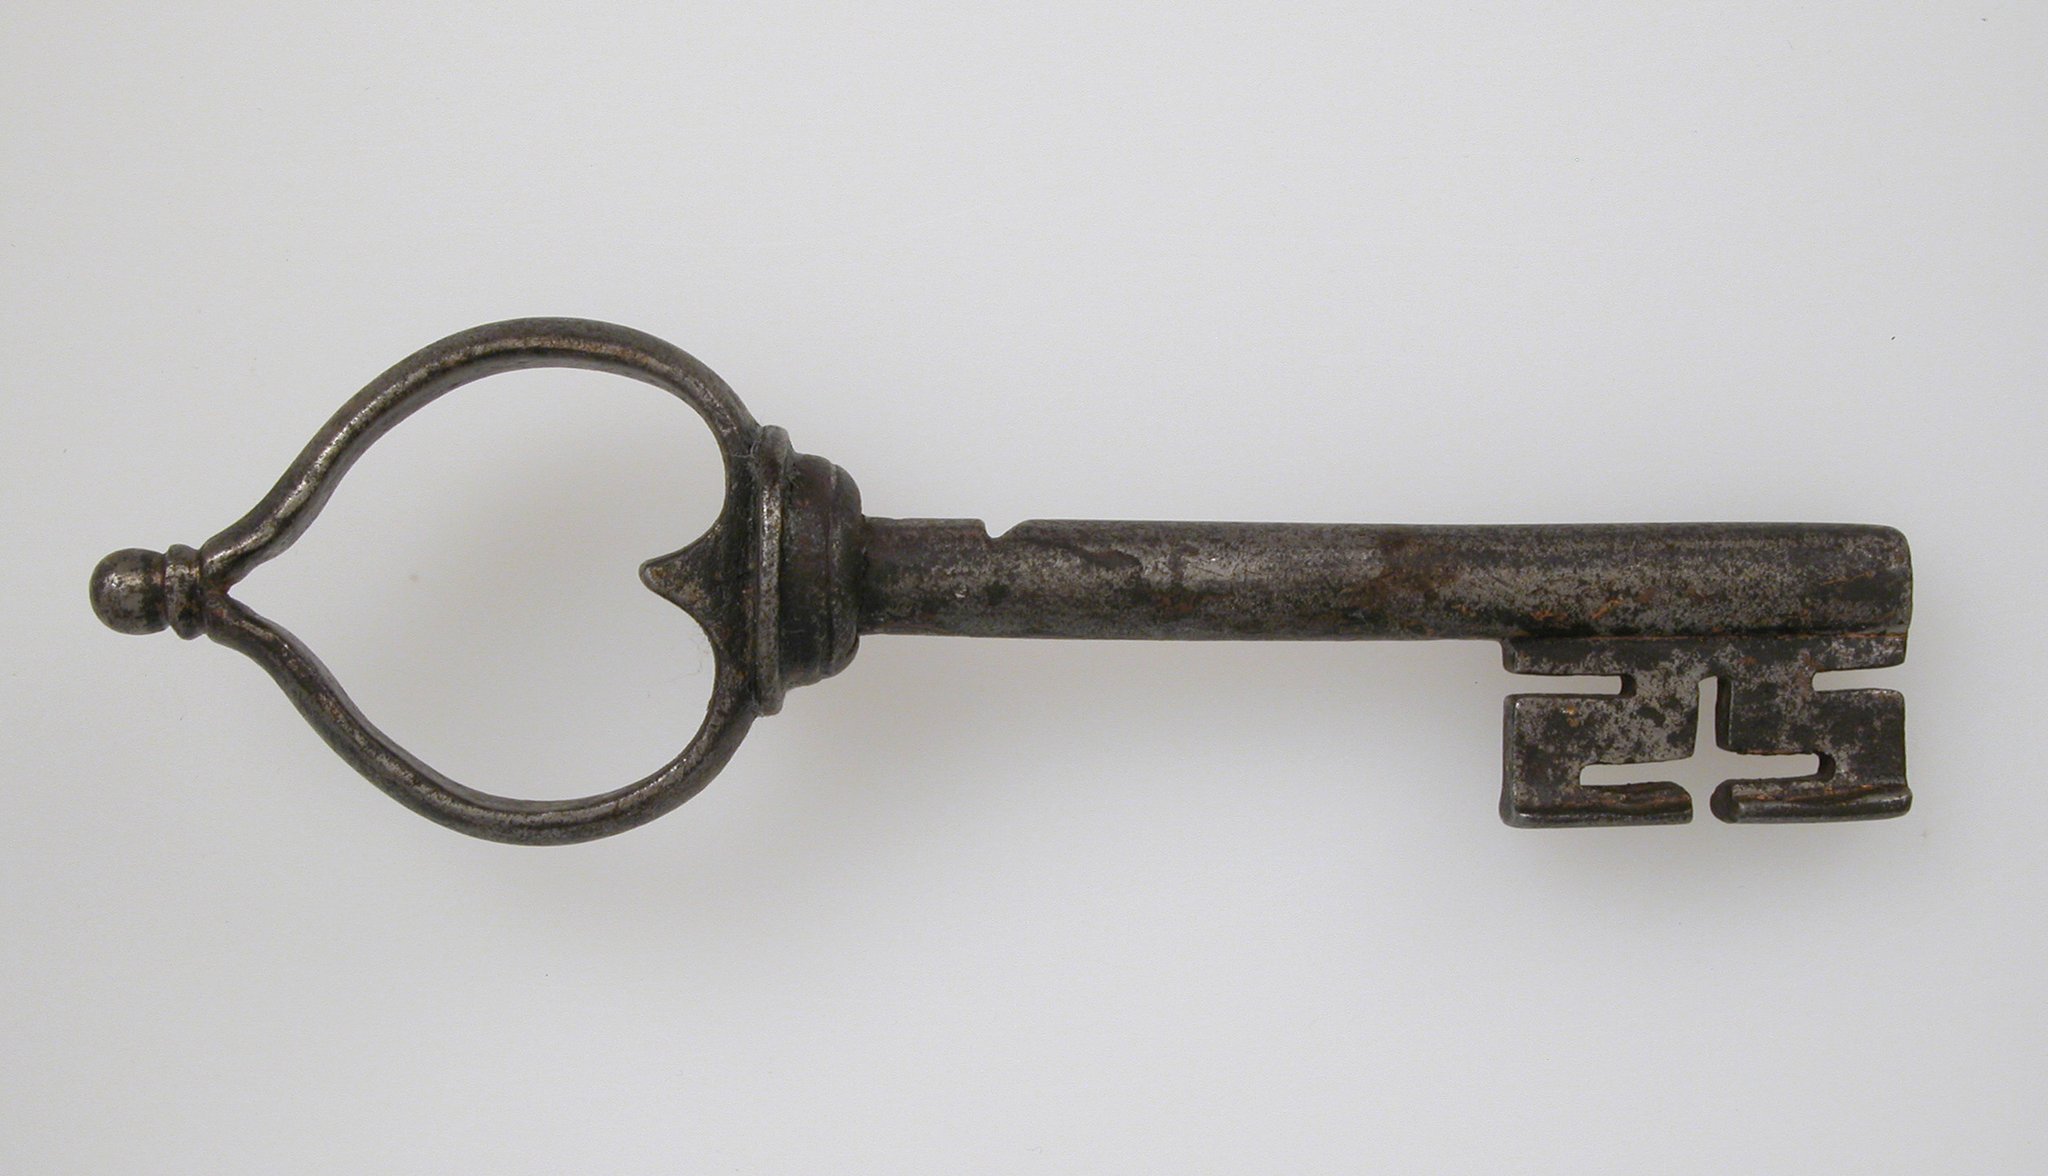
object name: key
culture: german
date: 1401-1500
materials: iron